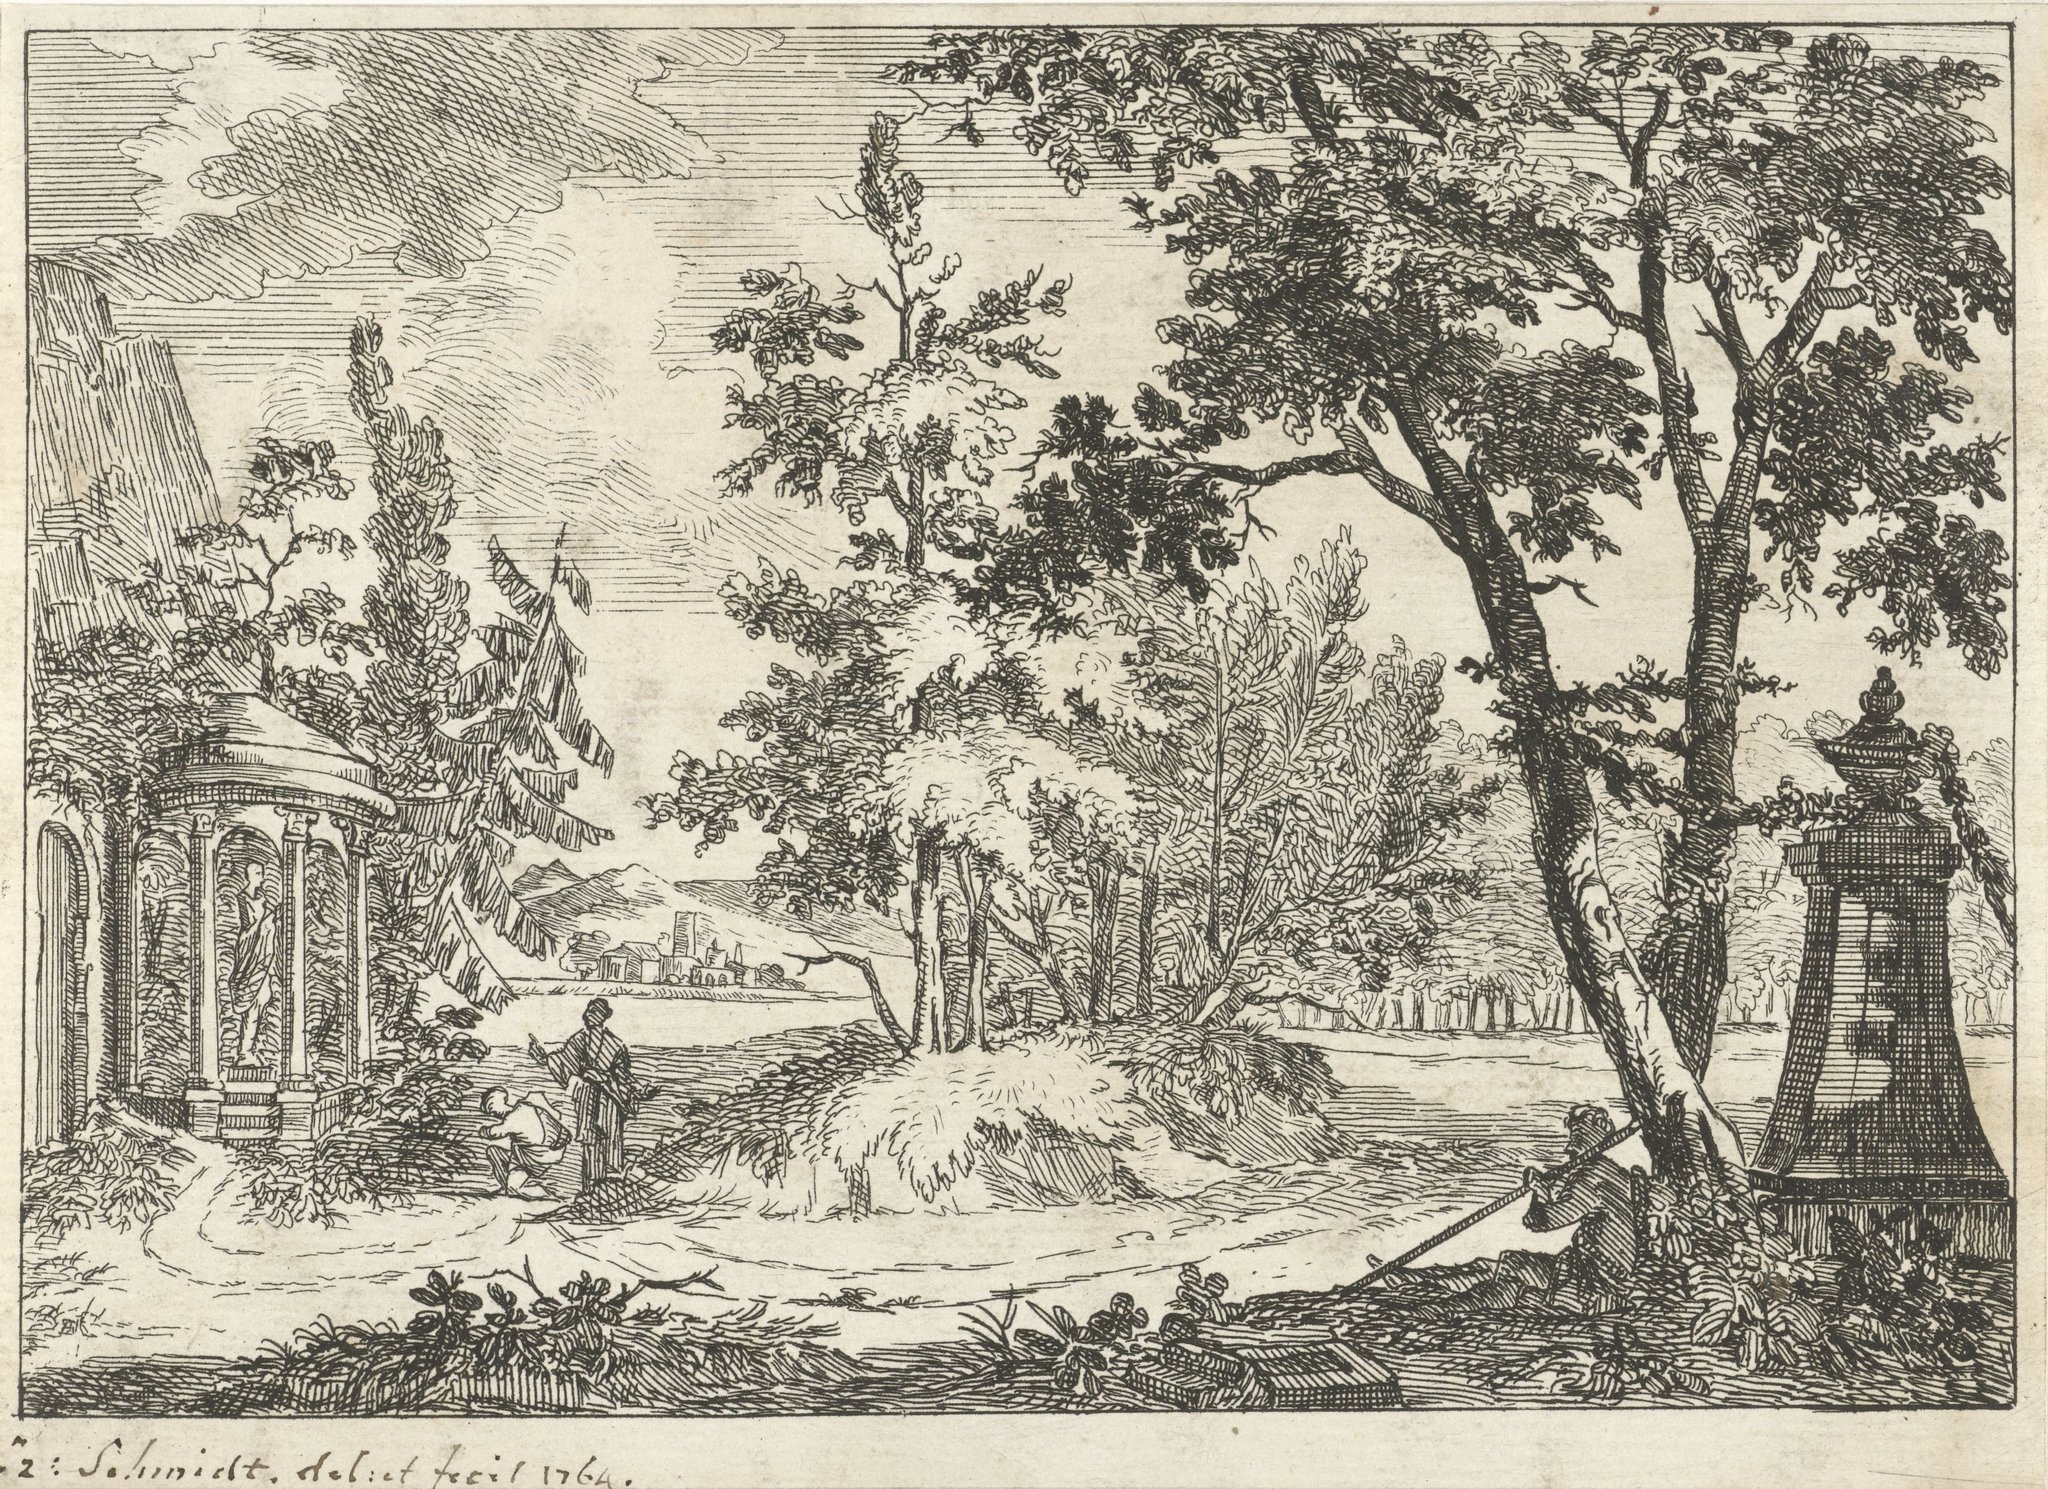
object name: print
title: Arcadisch landschap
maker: izaak schmidt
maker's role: draughtsman, print maker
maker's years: 1740-1818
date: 1764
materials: paper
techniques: etching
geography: amsterdam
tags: temple, shrine ~ shinto, herding, herdsman, herdswoman, shepherd, shepherdess, cowherd, etc.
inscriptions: collector's mark: Lugt 2228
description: Arcadisch landschap met een kleine tempel (met daarin een beeld) waarvoor een geknielde figuur zit. Op de voorgrond zit een herder bij een monument.